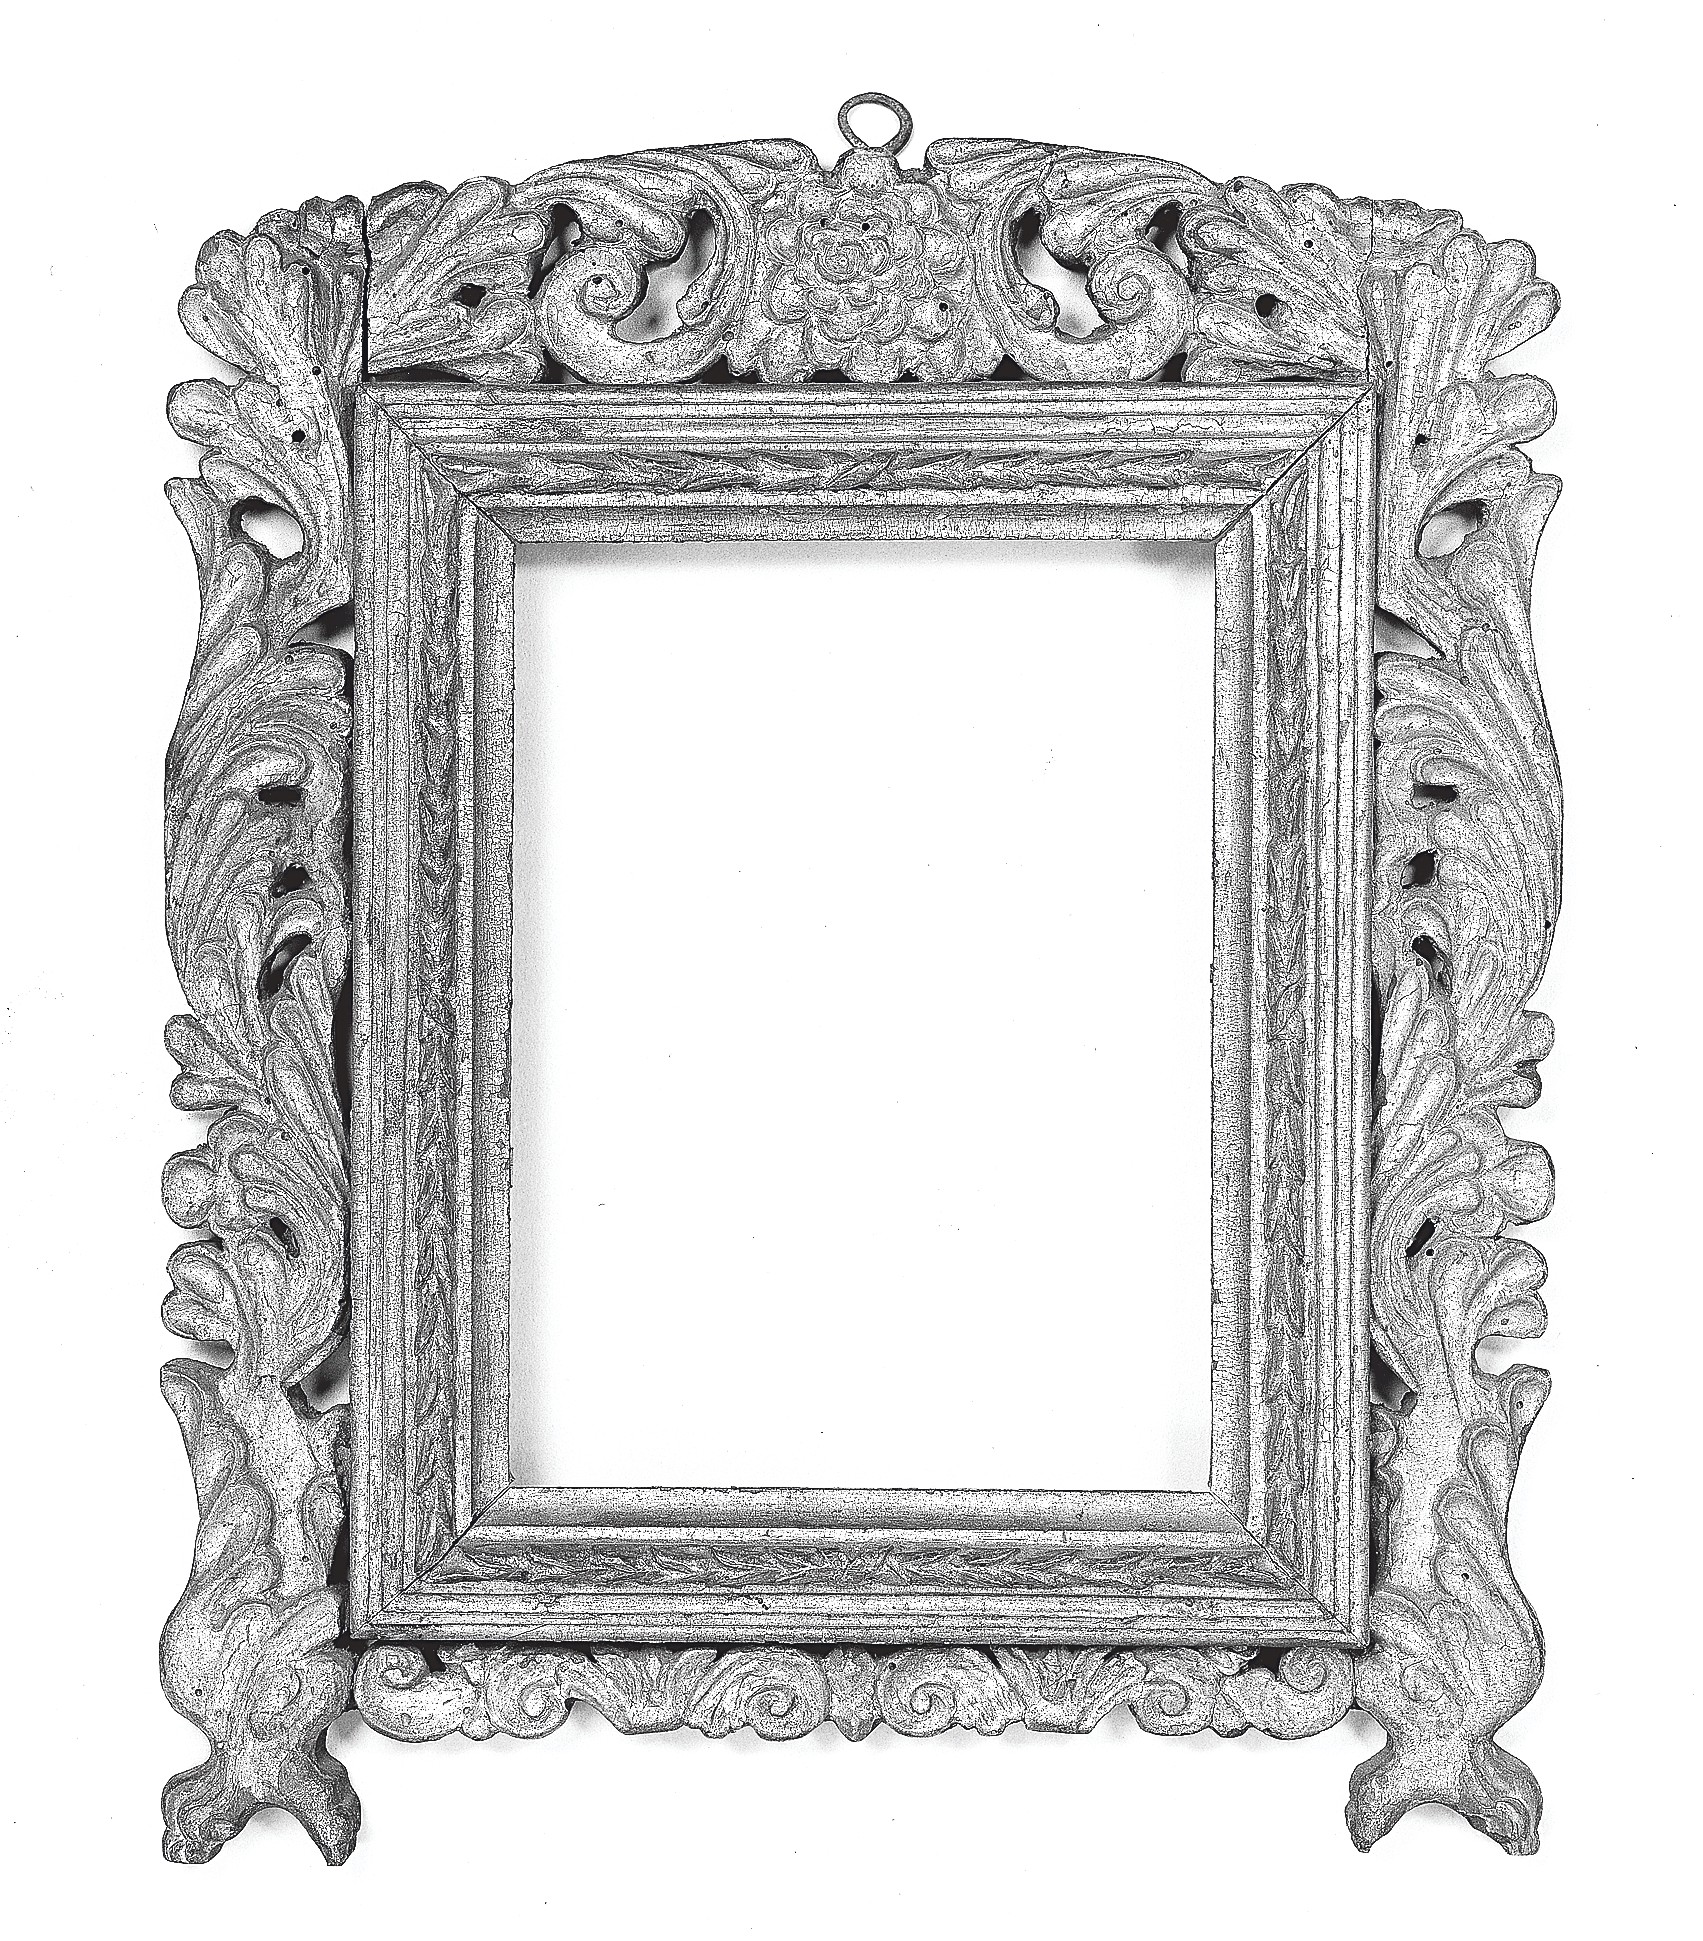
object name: frame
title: Mirror frame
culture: spanish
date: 1767-1800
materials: wood